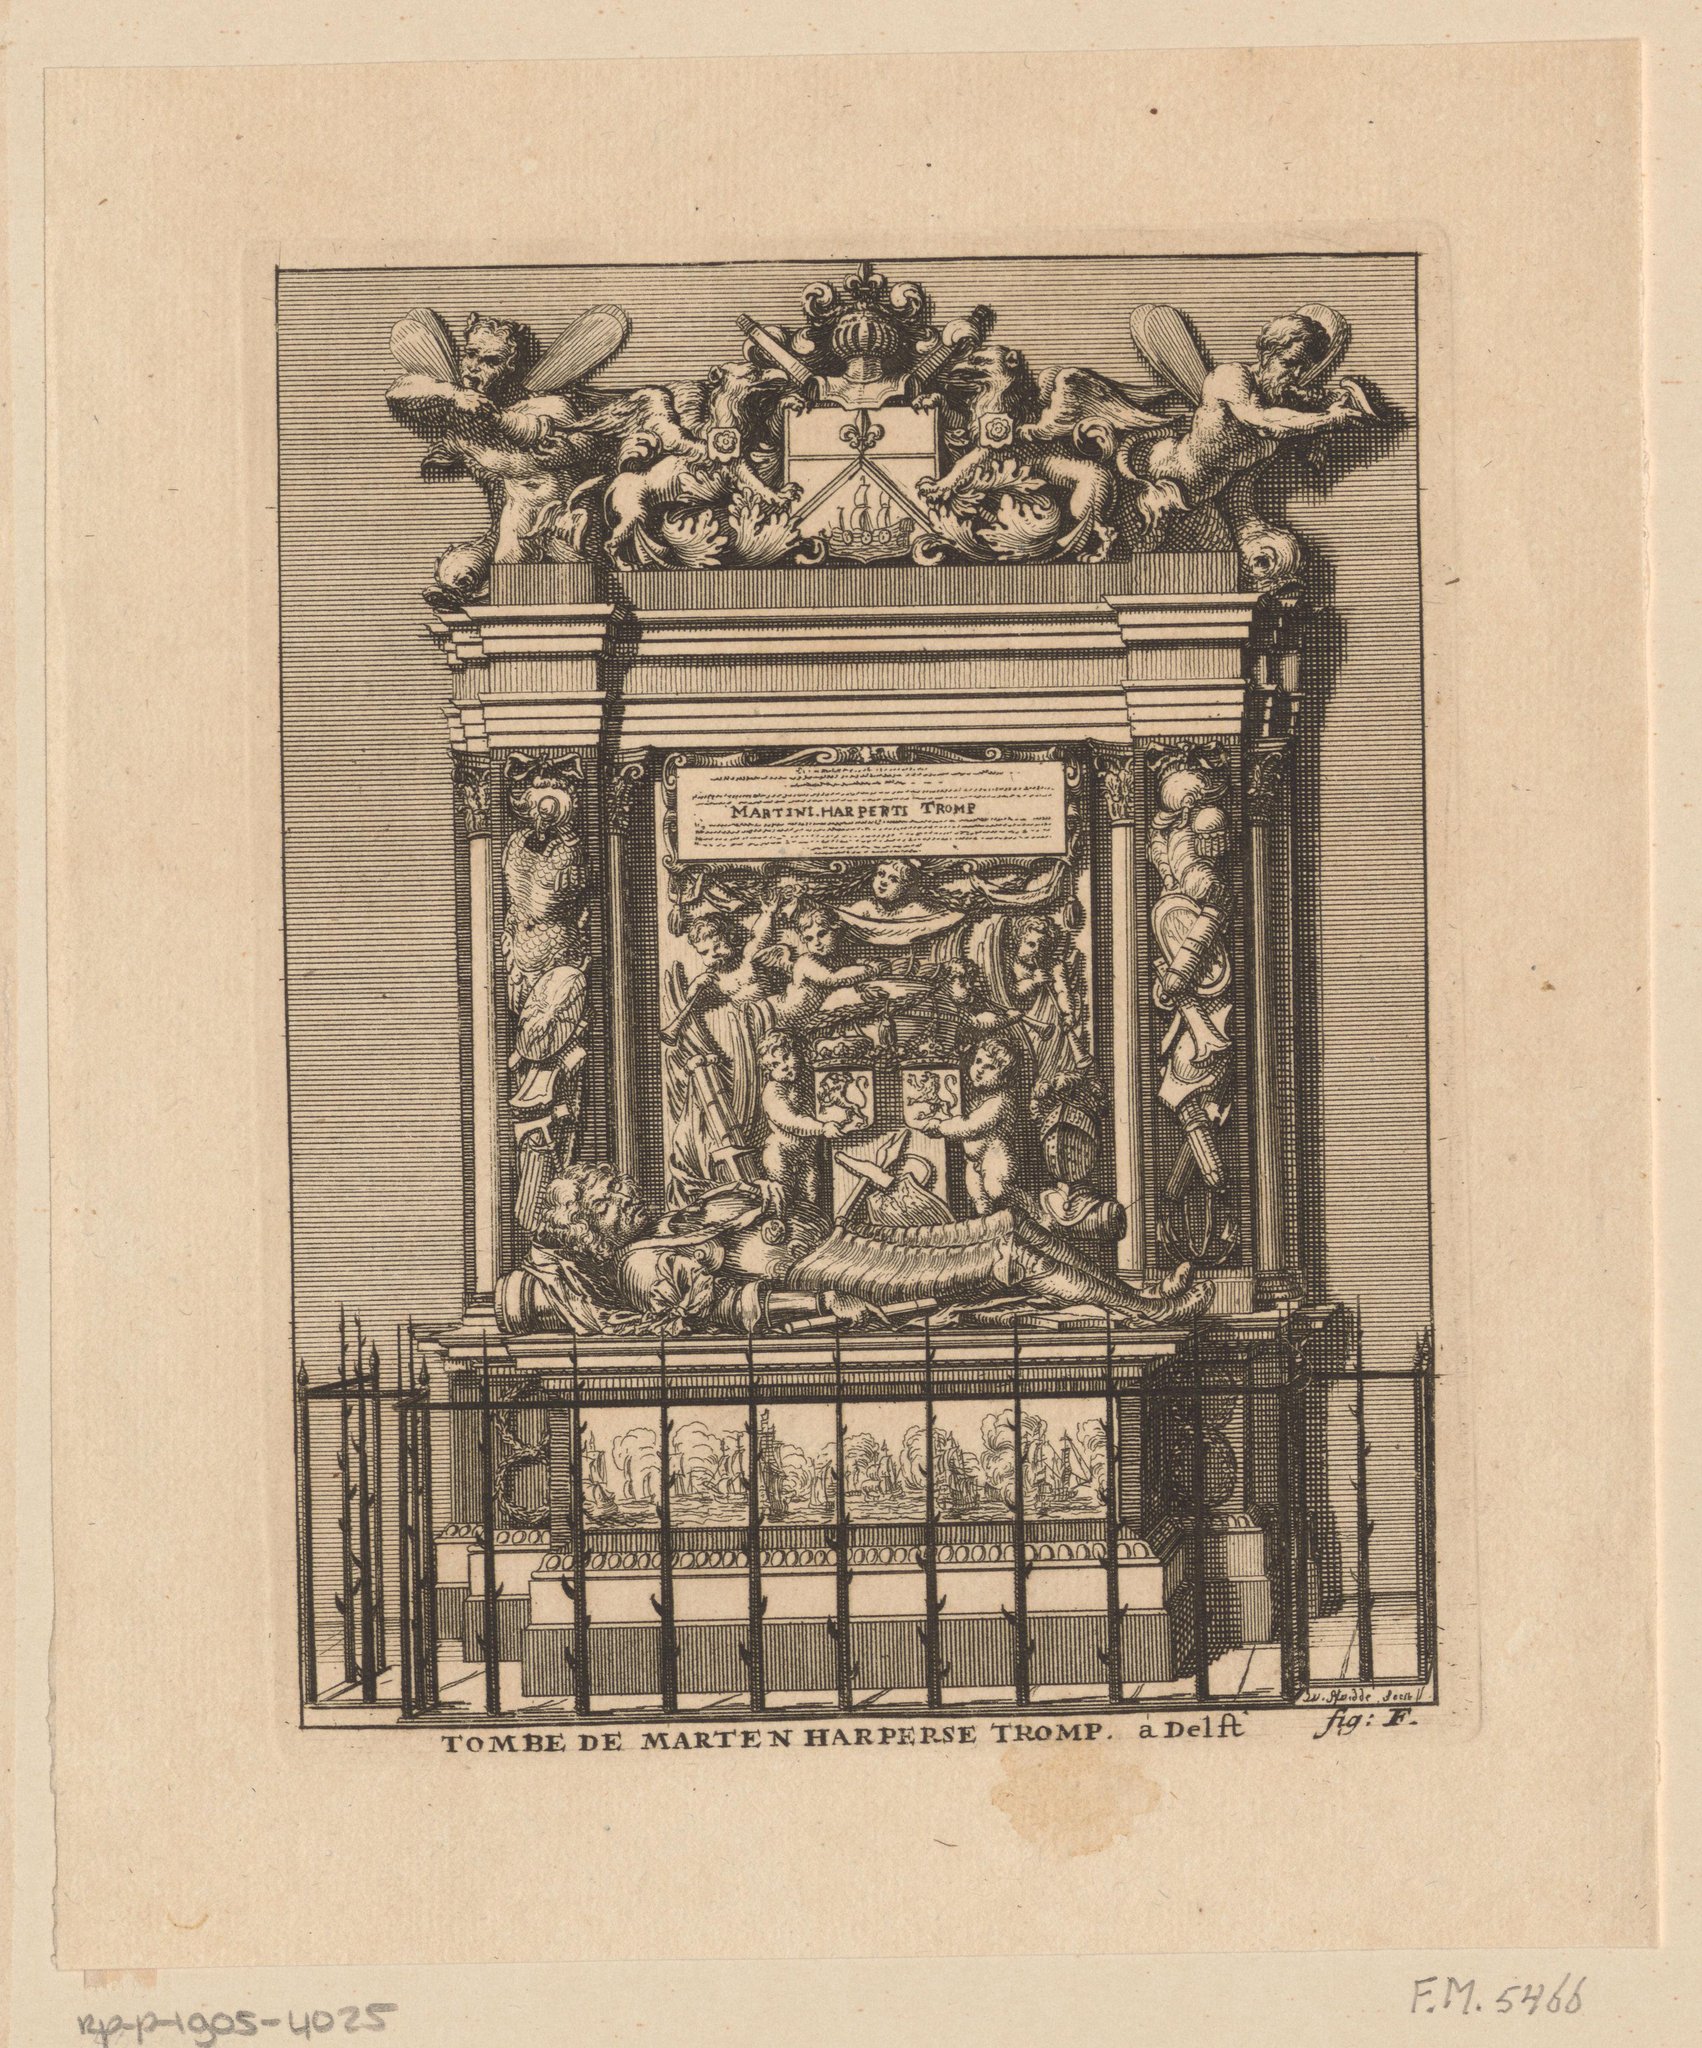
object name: print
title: Graftombe van Maarten Harpertszoon Tromp in de Oude Kerk te Delft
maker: willem swidde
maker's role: print maker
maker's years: 1660-1697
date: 1676-1688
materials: paper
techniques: etching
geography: amsterdam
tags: brielle, maarten harpertszoon tromp, grave, tomb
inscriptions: collector's mark: Lugt 2228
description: Prent waarschijnlijk uit: Nederlands helden-tooneel, vertoonende zeer cierlĳk in koper gesneeden alle de grafsteden, opgerecht ter eere der dappere mannen, welke hun leven ten dienste des vaderlands opgeofferd hebben. S.l.s.n., [eind 17e eeuw]. Prent ook gebruikt in: Bizot, Pierre. Medalische historie der republyk van Holland. Amsterdam: Pieter Mortier, 1690, dl. 1.